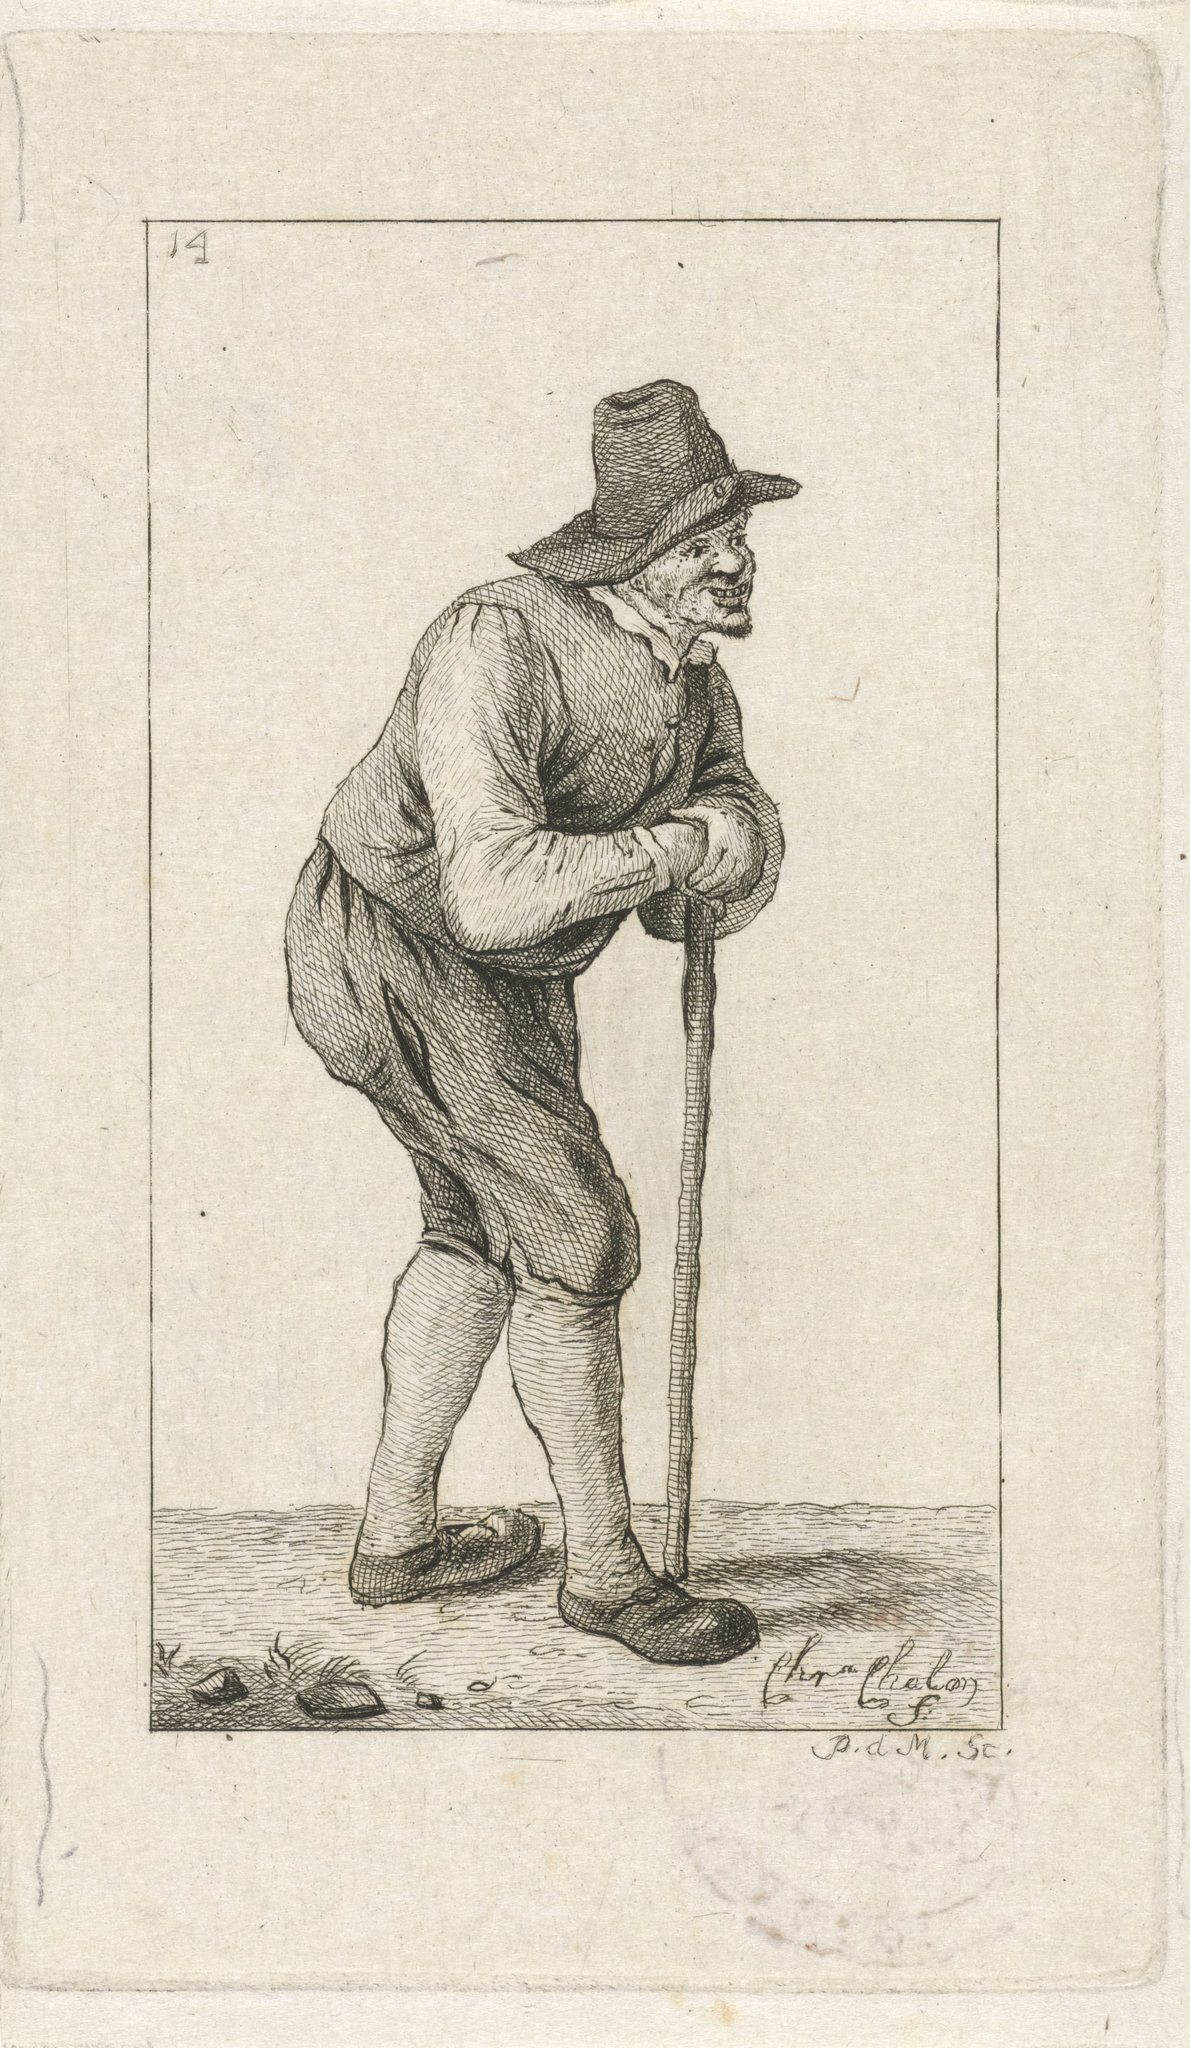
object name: print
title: Man leunend op stok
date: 1779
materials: paper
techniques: etching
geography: leiden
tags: walking-stick, staff, leaning figure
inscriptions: collector's mark: Lugt 240